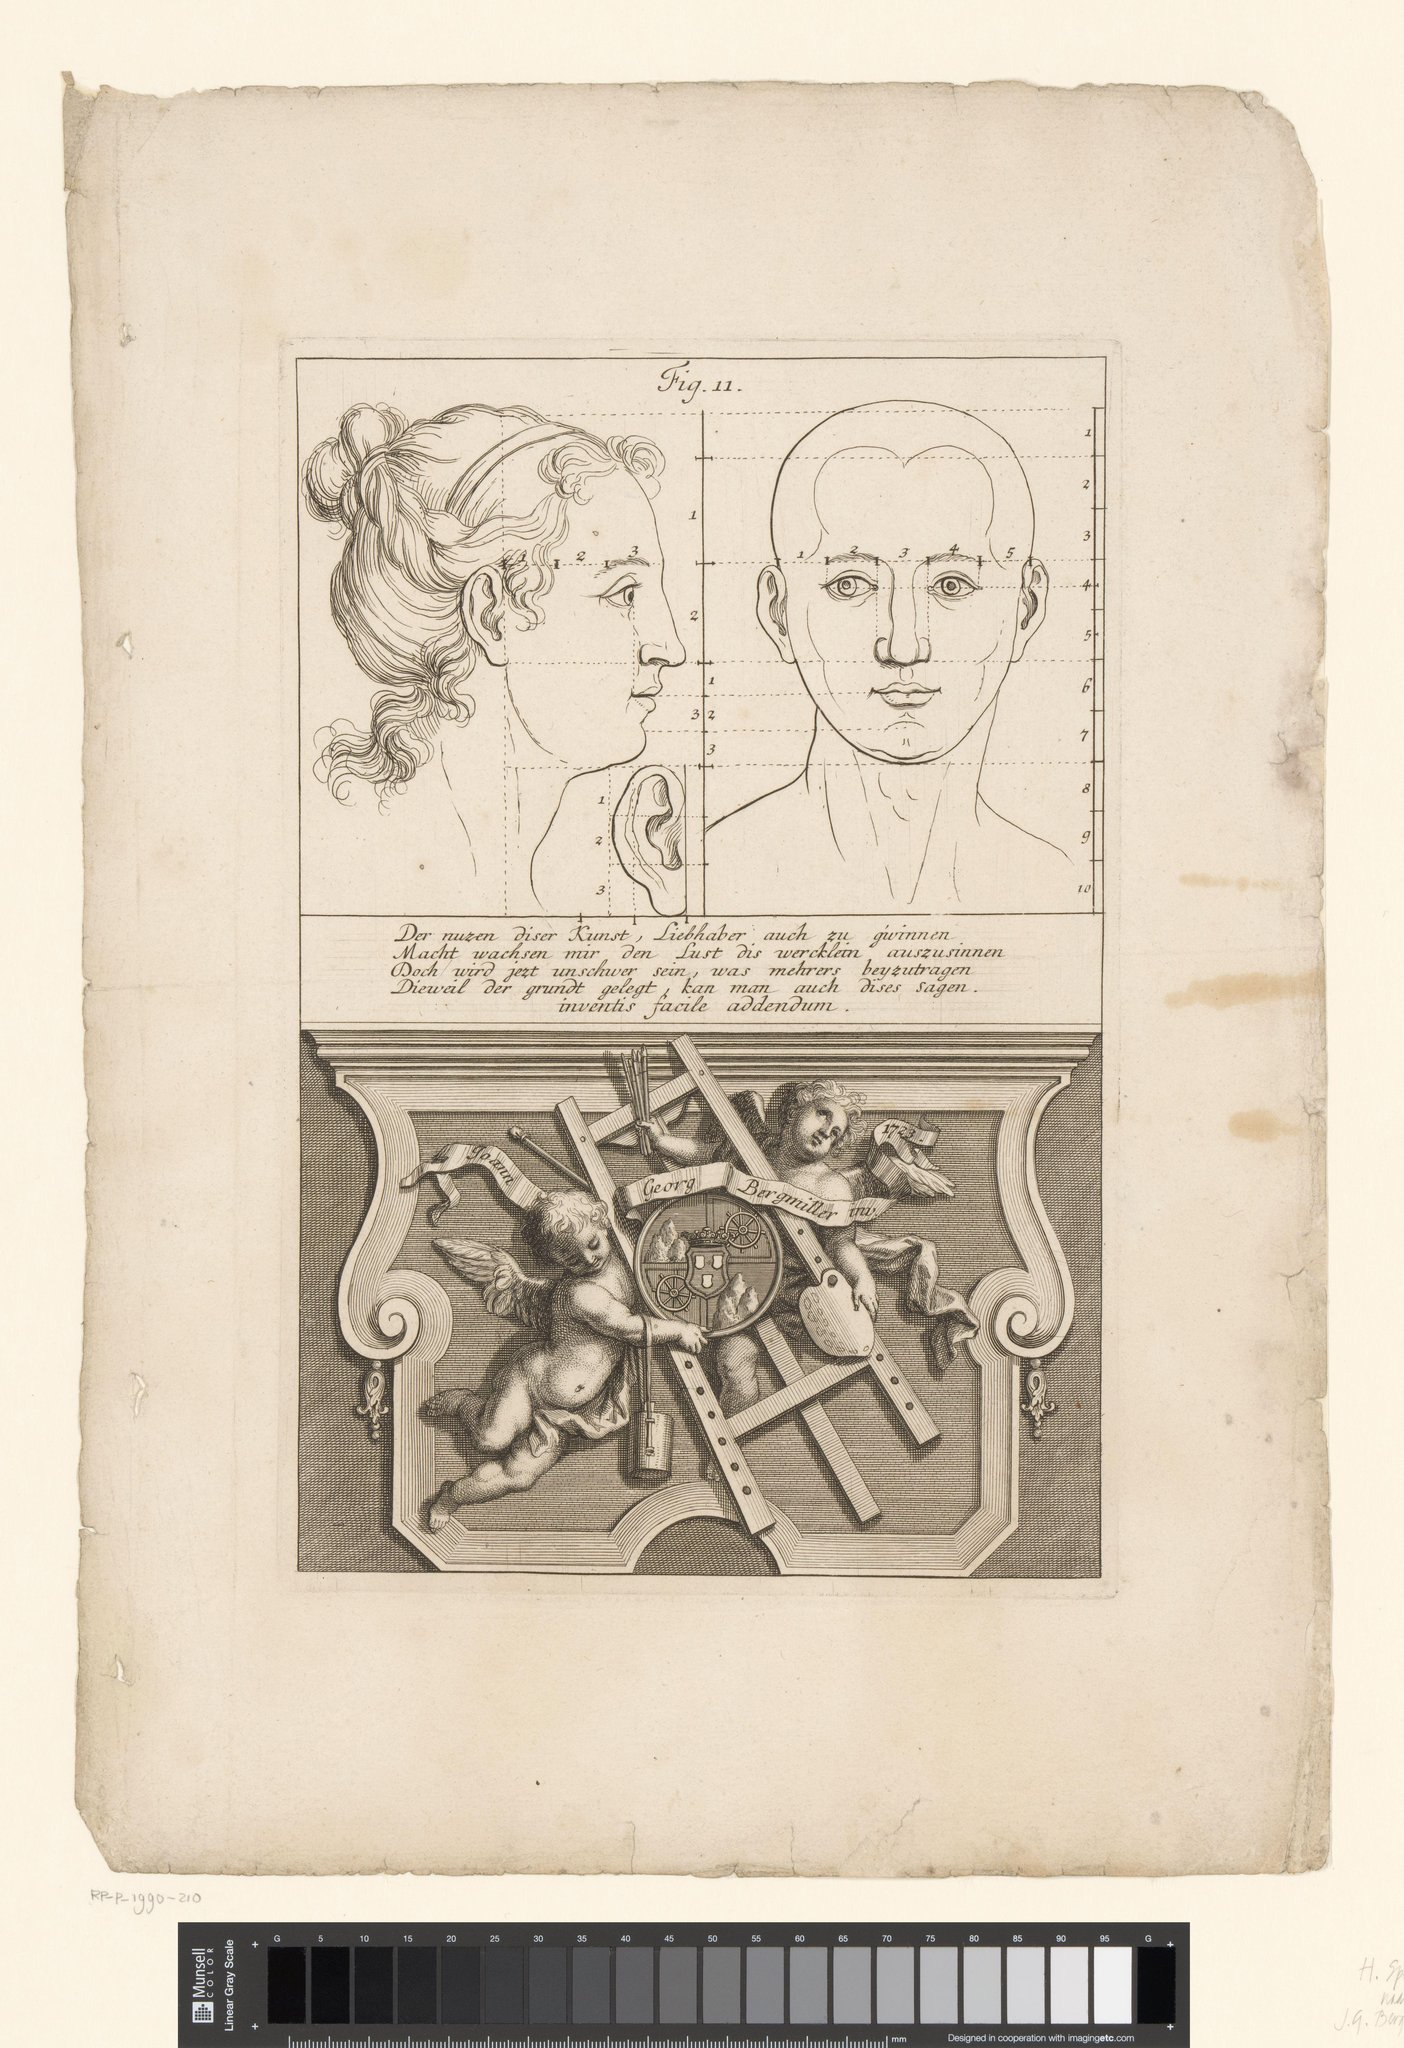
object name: book illustration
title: Schematische weergave van vrouwelijk en mannelijk gezicht en twee putti met wapenschild en schildersezel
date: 1723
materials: paper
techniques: etching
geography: augsburg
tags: face, the (nude) human figure; 'corpo humano' (ripa), tools, implements of painter, postures of the head, the (nude) human figure; 'corpo humano' (ripa) - aa - female human figure, cupids: 'amores', 'amoretti', 'putti'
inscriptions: collector's mark: Lugt 2760, collector's mark: Lugt 2228, collector's mark: Lugt 1012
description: Prent uit een leerboek over proportieleer: Anthropometria, sive statura hominis. Augsburg: Johann Jacob Lotter, 1723.